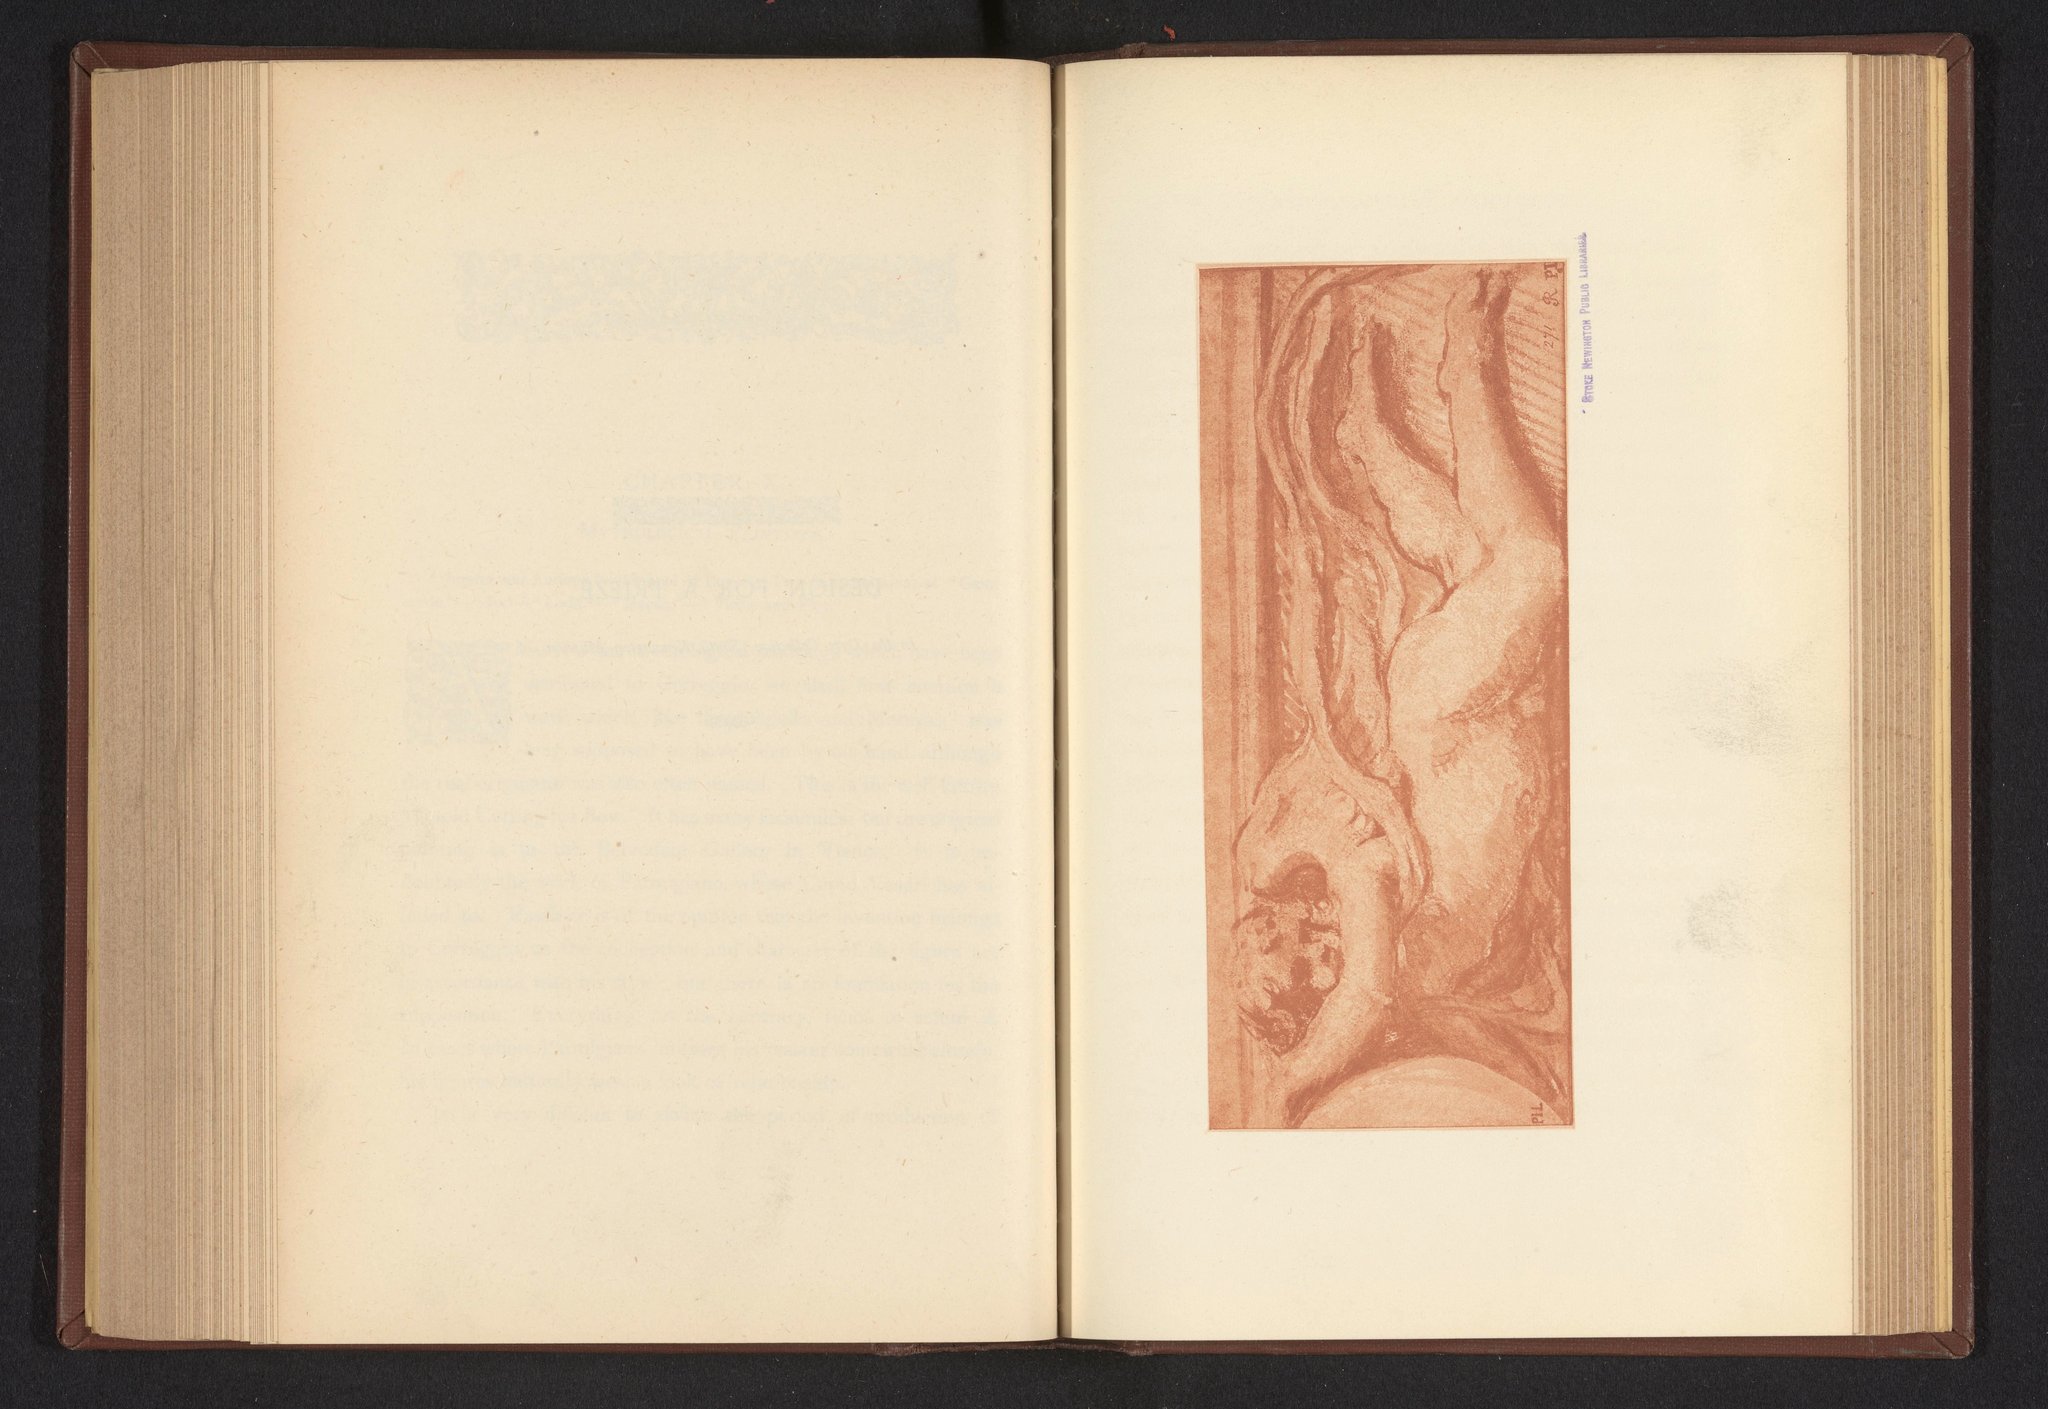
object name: page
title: Fotoreproductie van een tekening, voorstellende een putto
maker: Anonymous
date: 1870-1876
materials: paper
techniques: photograph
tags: cupids: 'amores', 'amoretti', 'putti'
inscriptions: inscription: ‘Stoke Newington Public Libraries’